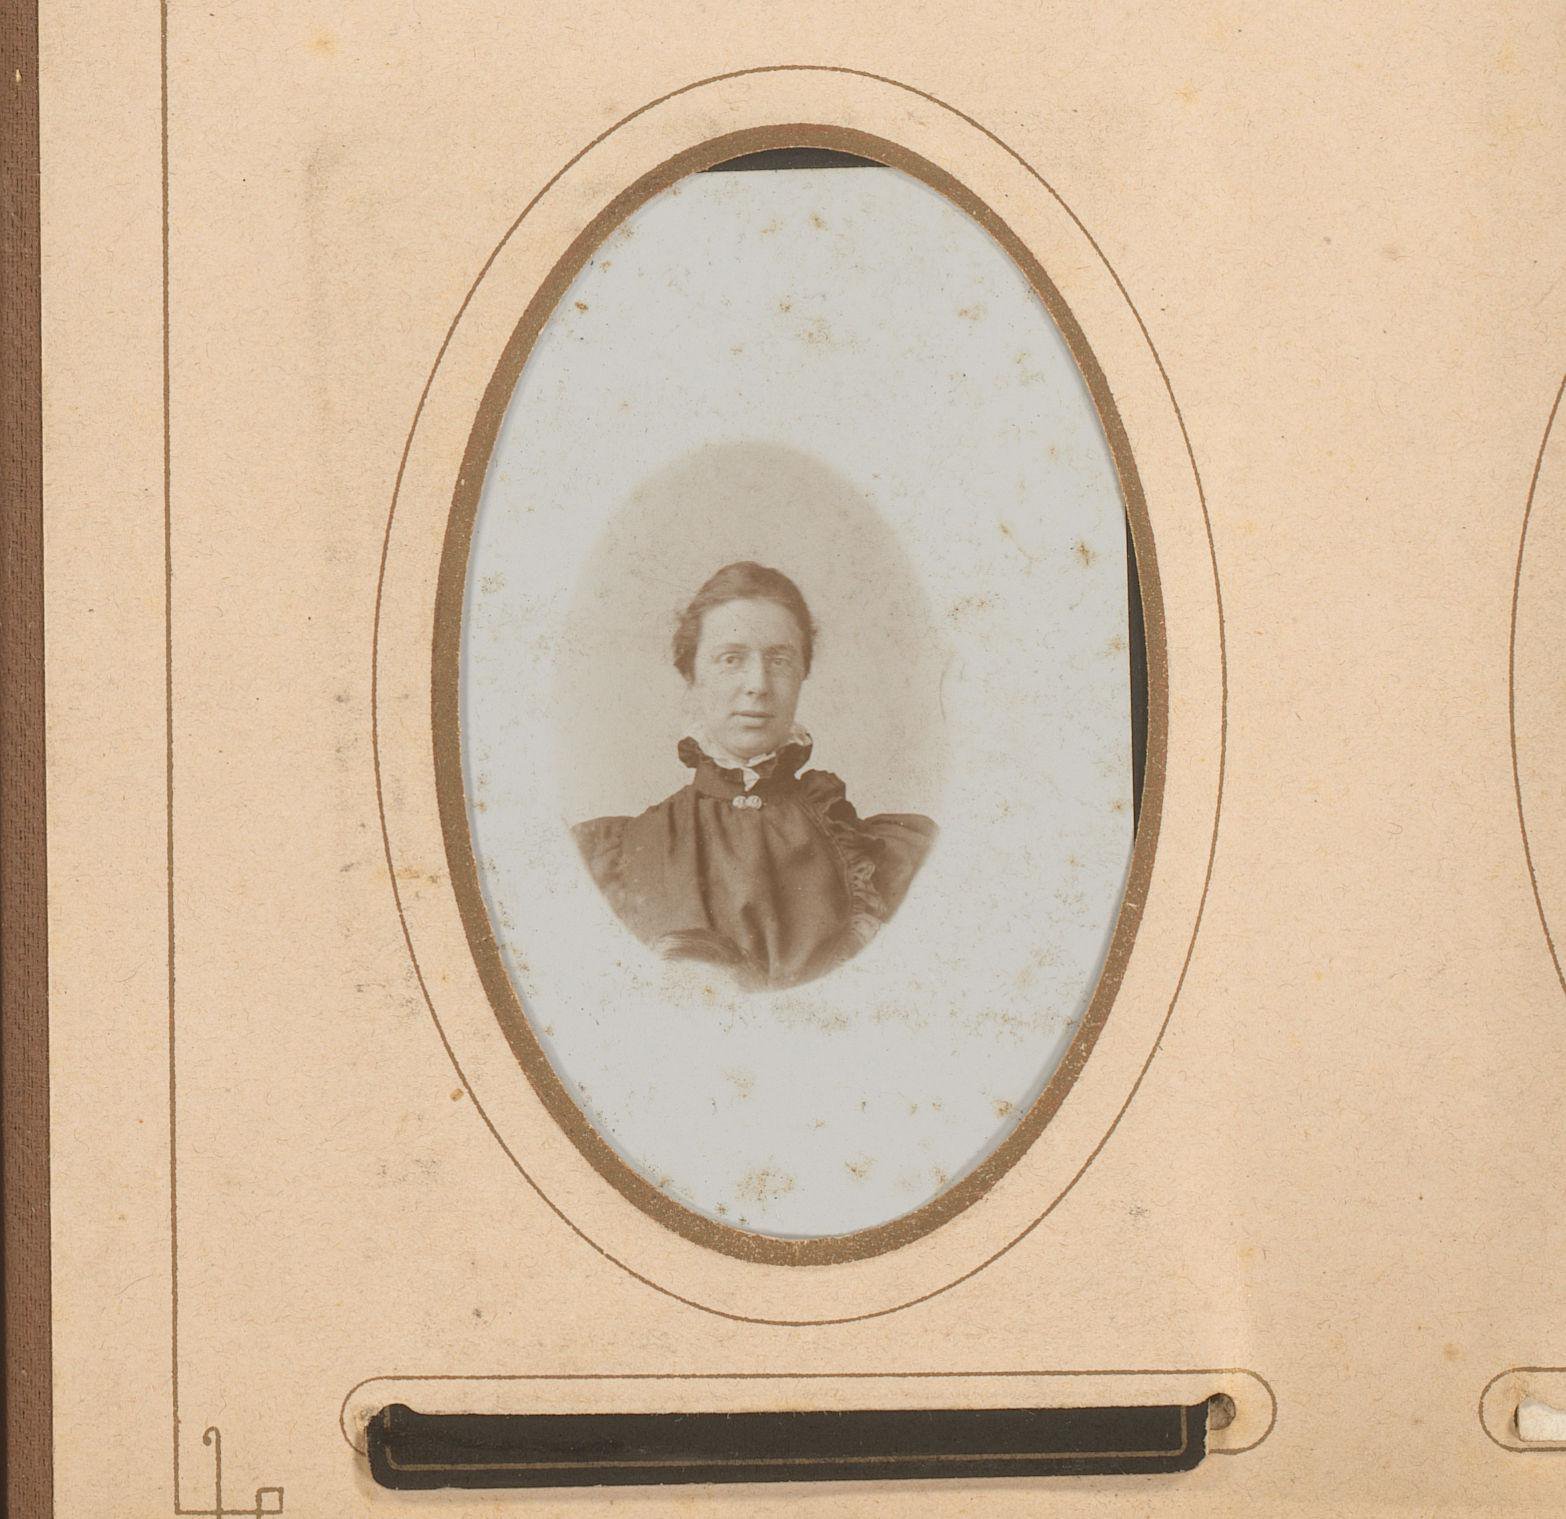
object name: album leaf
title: Portret van een vrouw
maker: Anonymous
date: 1880-1910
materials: cardboard, photographic support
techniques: albumen print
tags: adolescent, young woman, maiden, historical persons - bb - woman